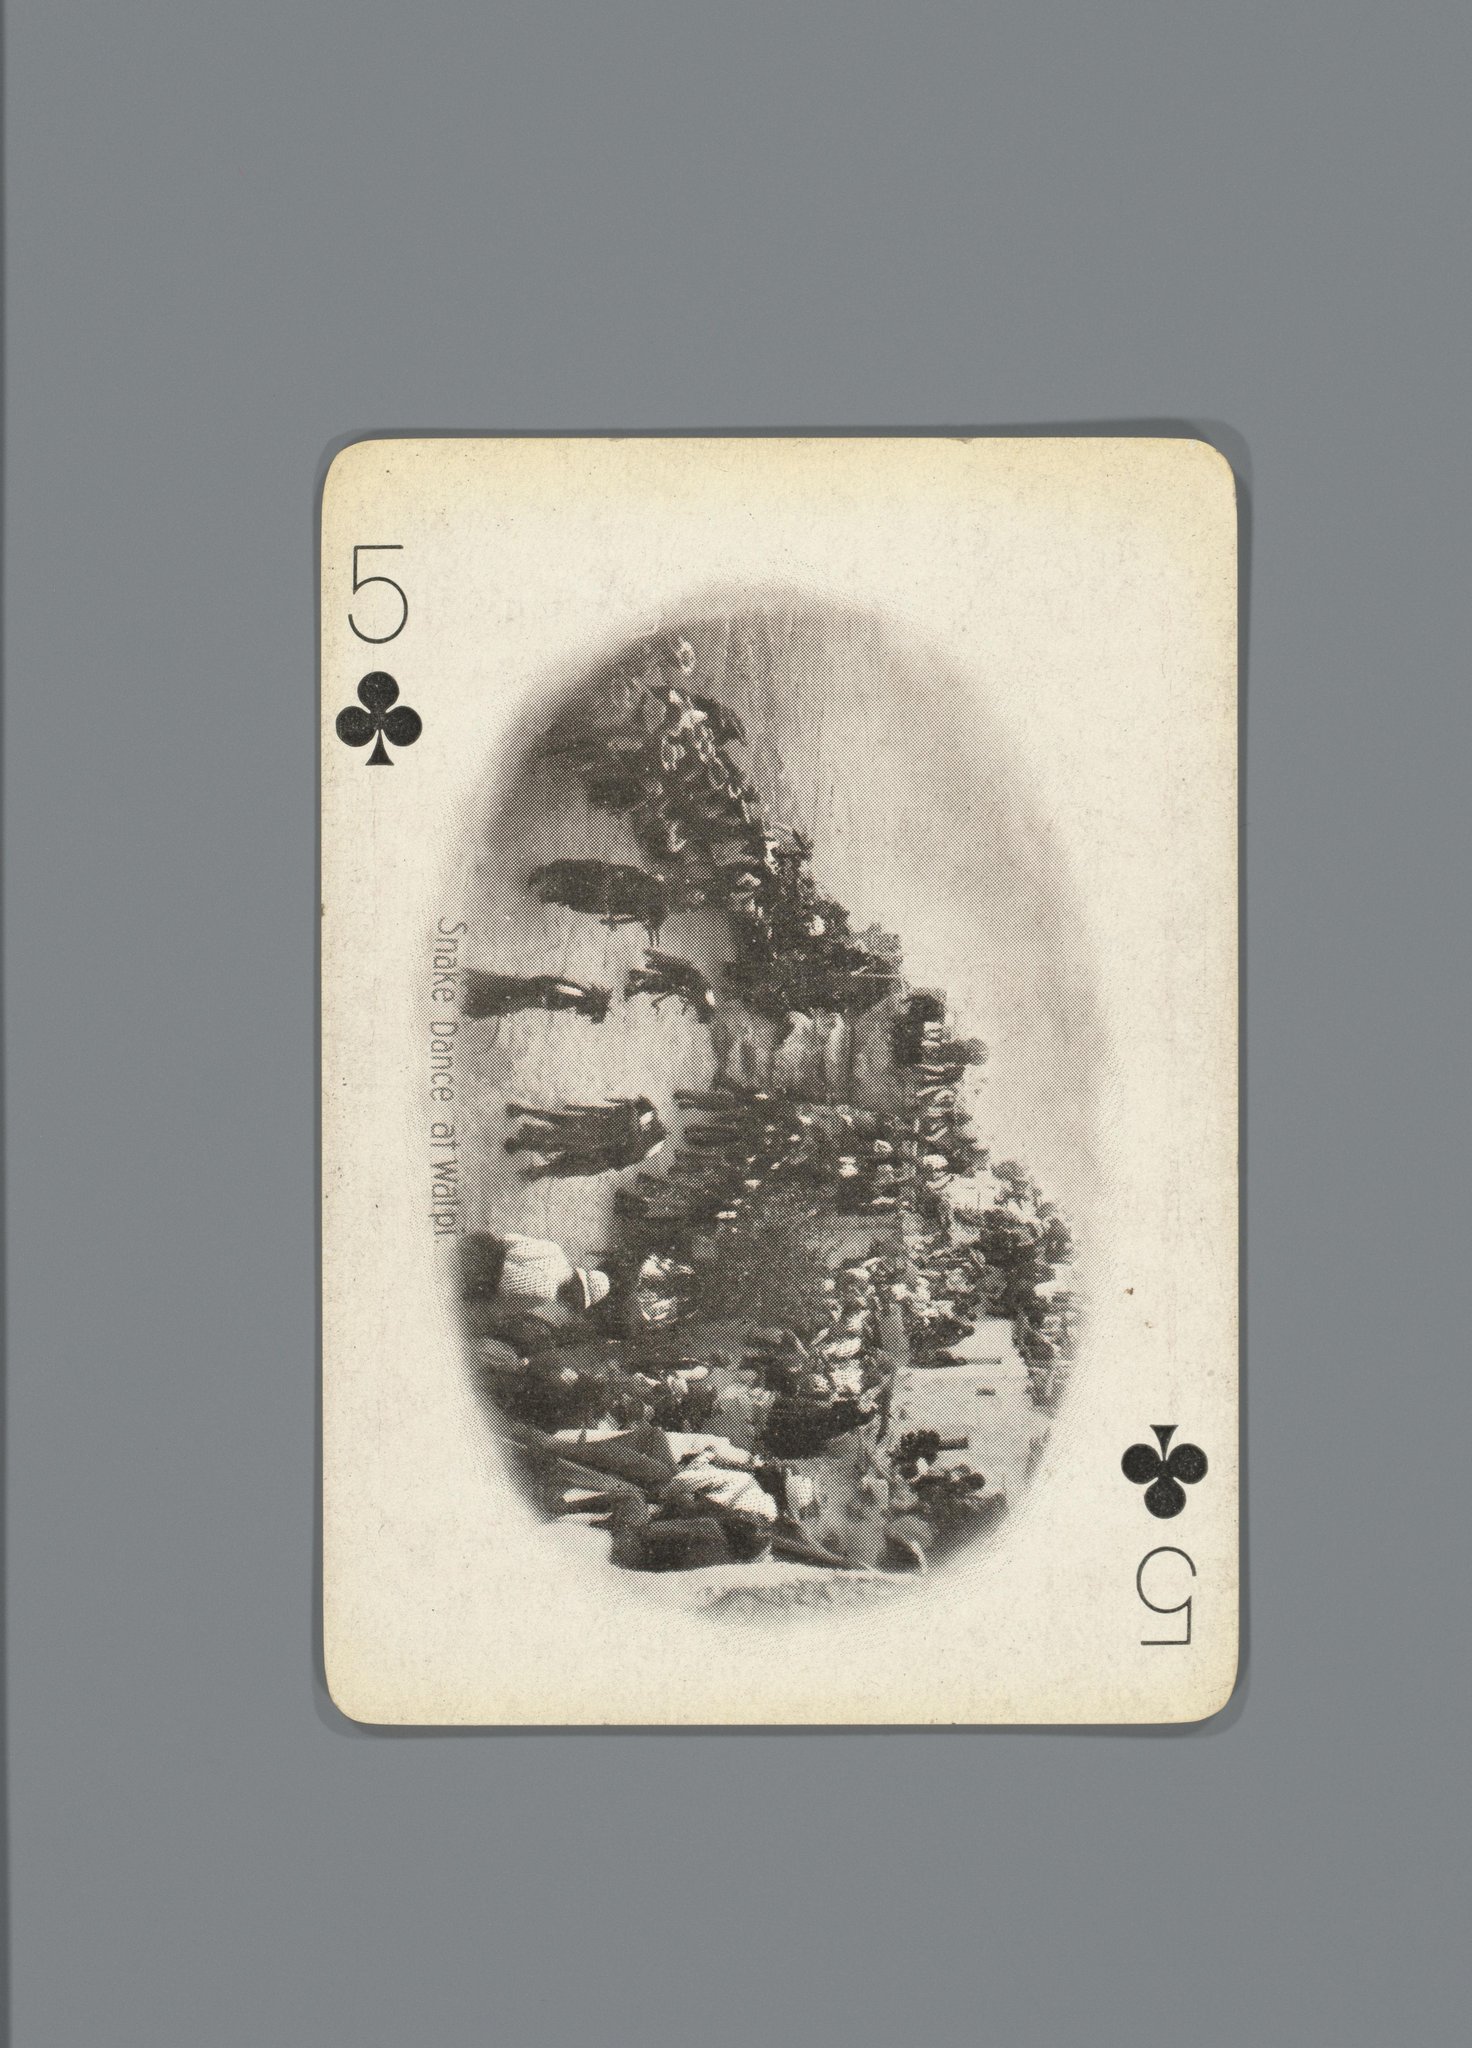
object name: playing card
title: Snake Dance at Walpi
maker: adam clark vroman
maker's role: fotograaf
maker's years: 1856-1916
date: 1900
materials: paper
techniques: autotype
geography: los angeles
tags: arizona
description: Speelkaart uit doosje met 53 speelkaarten met afbeeldingen in autotypie van Native Americans. De inhoud bevat een complete set speelkaarten inclusief joker.